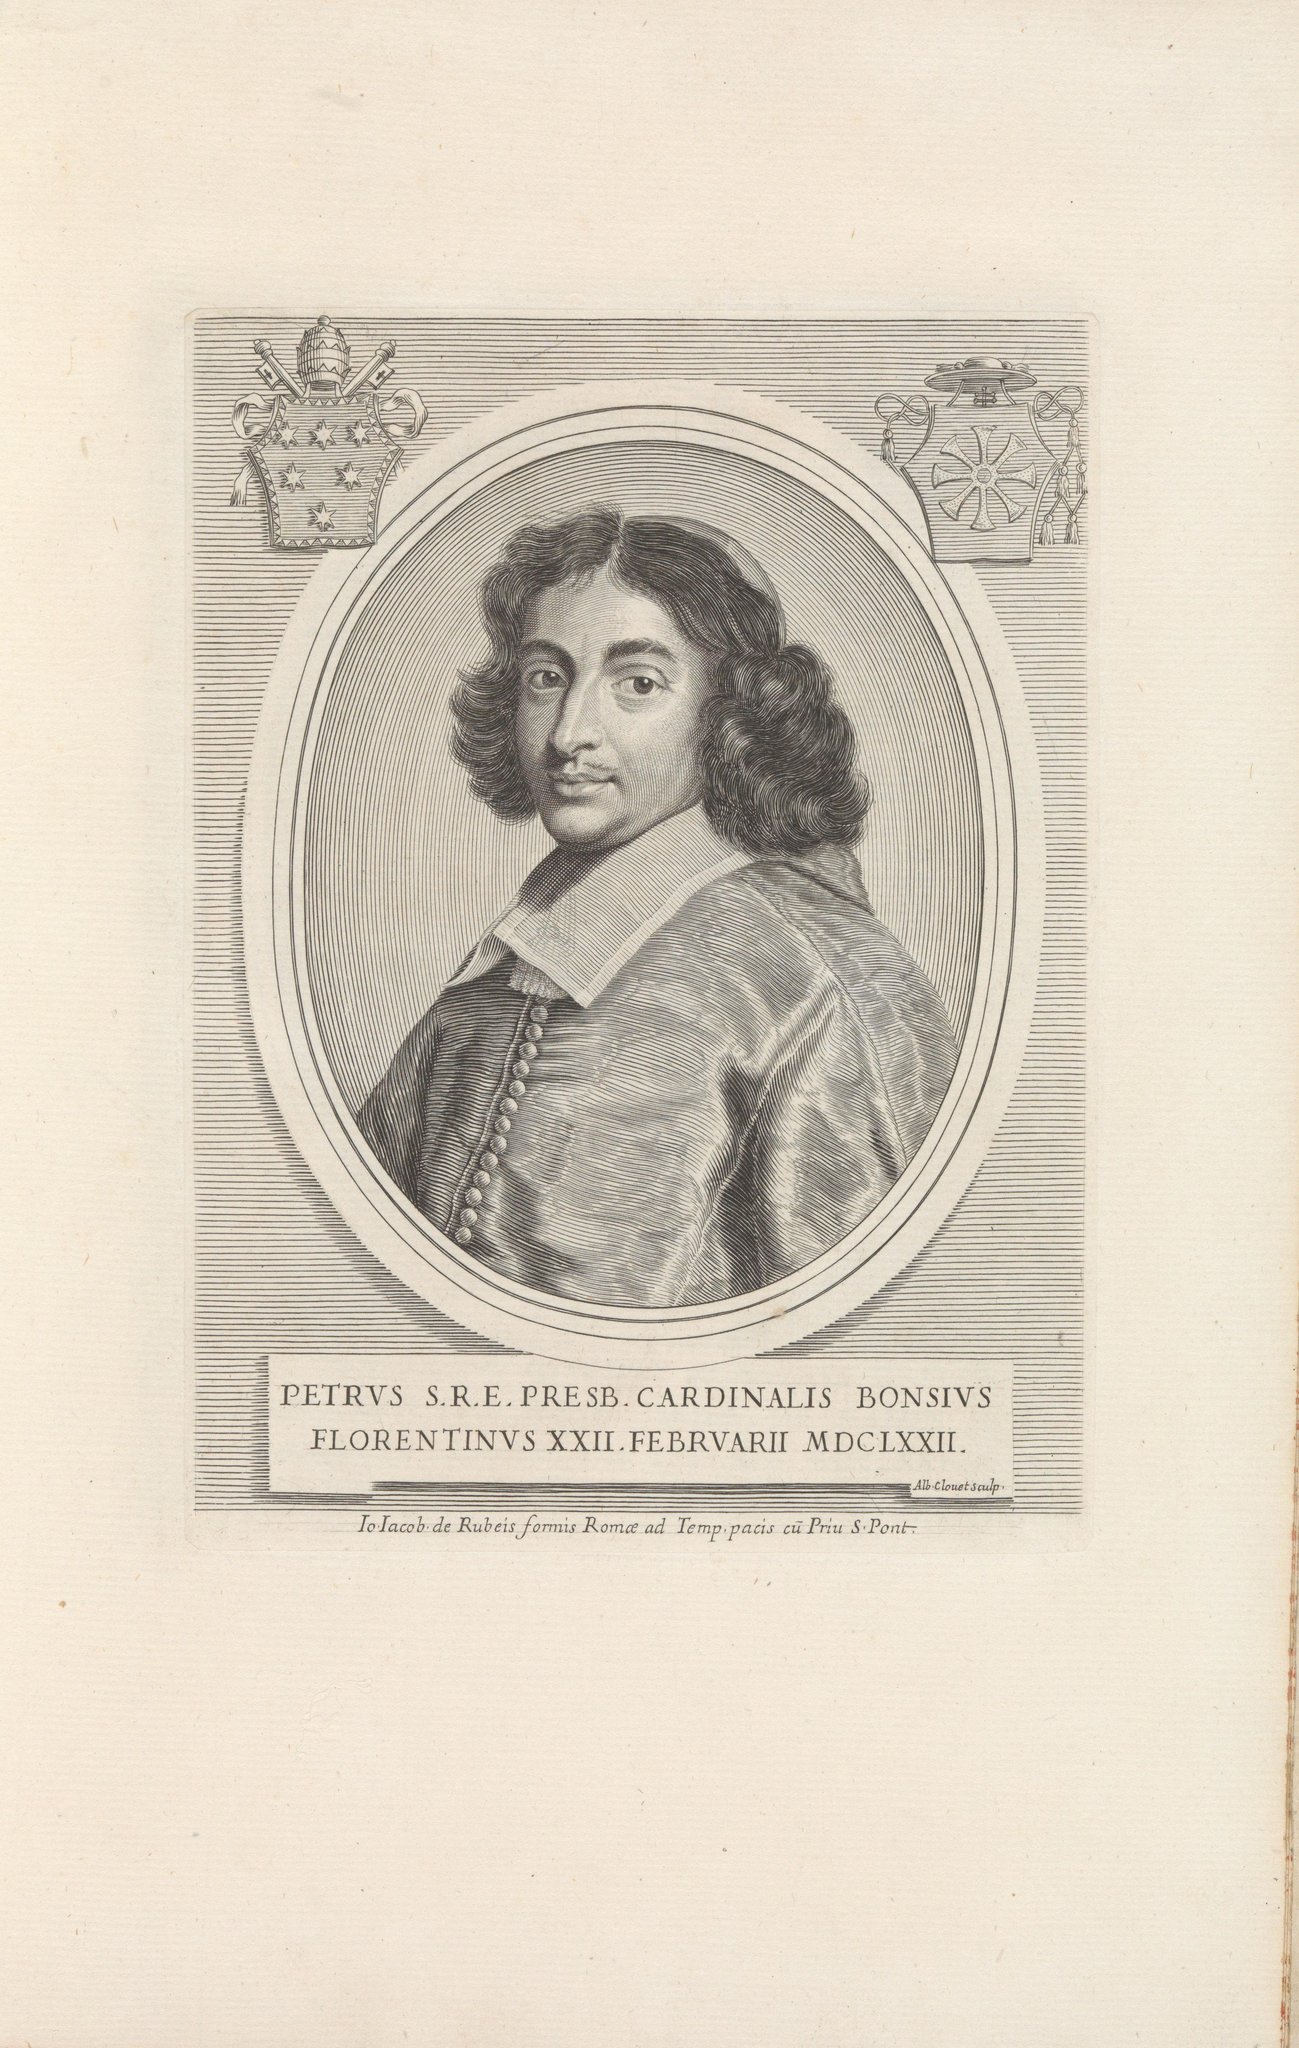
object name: print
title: Portret van kardinaal Pierre de Bonzi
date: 1672-1679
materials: paper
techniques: engraving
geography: rome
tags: pierre de bonzi, cardinal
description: Portret van kardinaal Pierre de Bonzi. Linksboven het wapen van paus Clemens X en rechtsboven het wapen van de kardinaal. Onderaan een onderschrift in het Latijn. De prent maakt deel uit van een album.